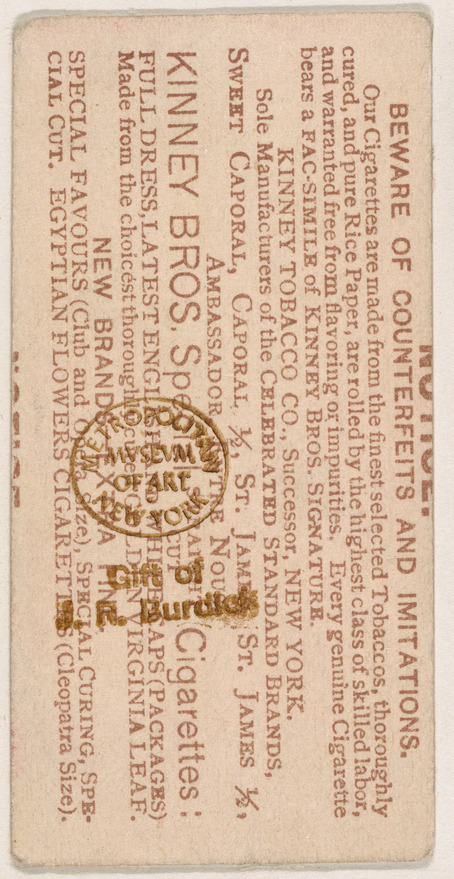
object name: print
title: Example of one variety of card verso, from the Military Series (N224) issued by Kinney Tobacco Company to promote Sweet Caporal Cigarettes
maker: kinney brothers tobacco company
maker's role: publisher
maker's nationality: american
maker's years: 1869-2011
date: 1888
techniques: color lithograph